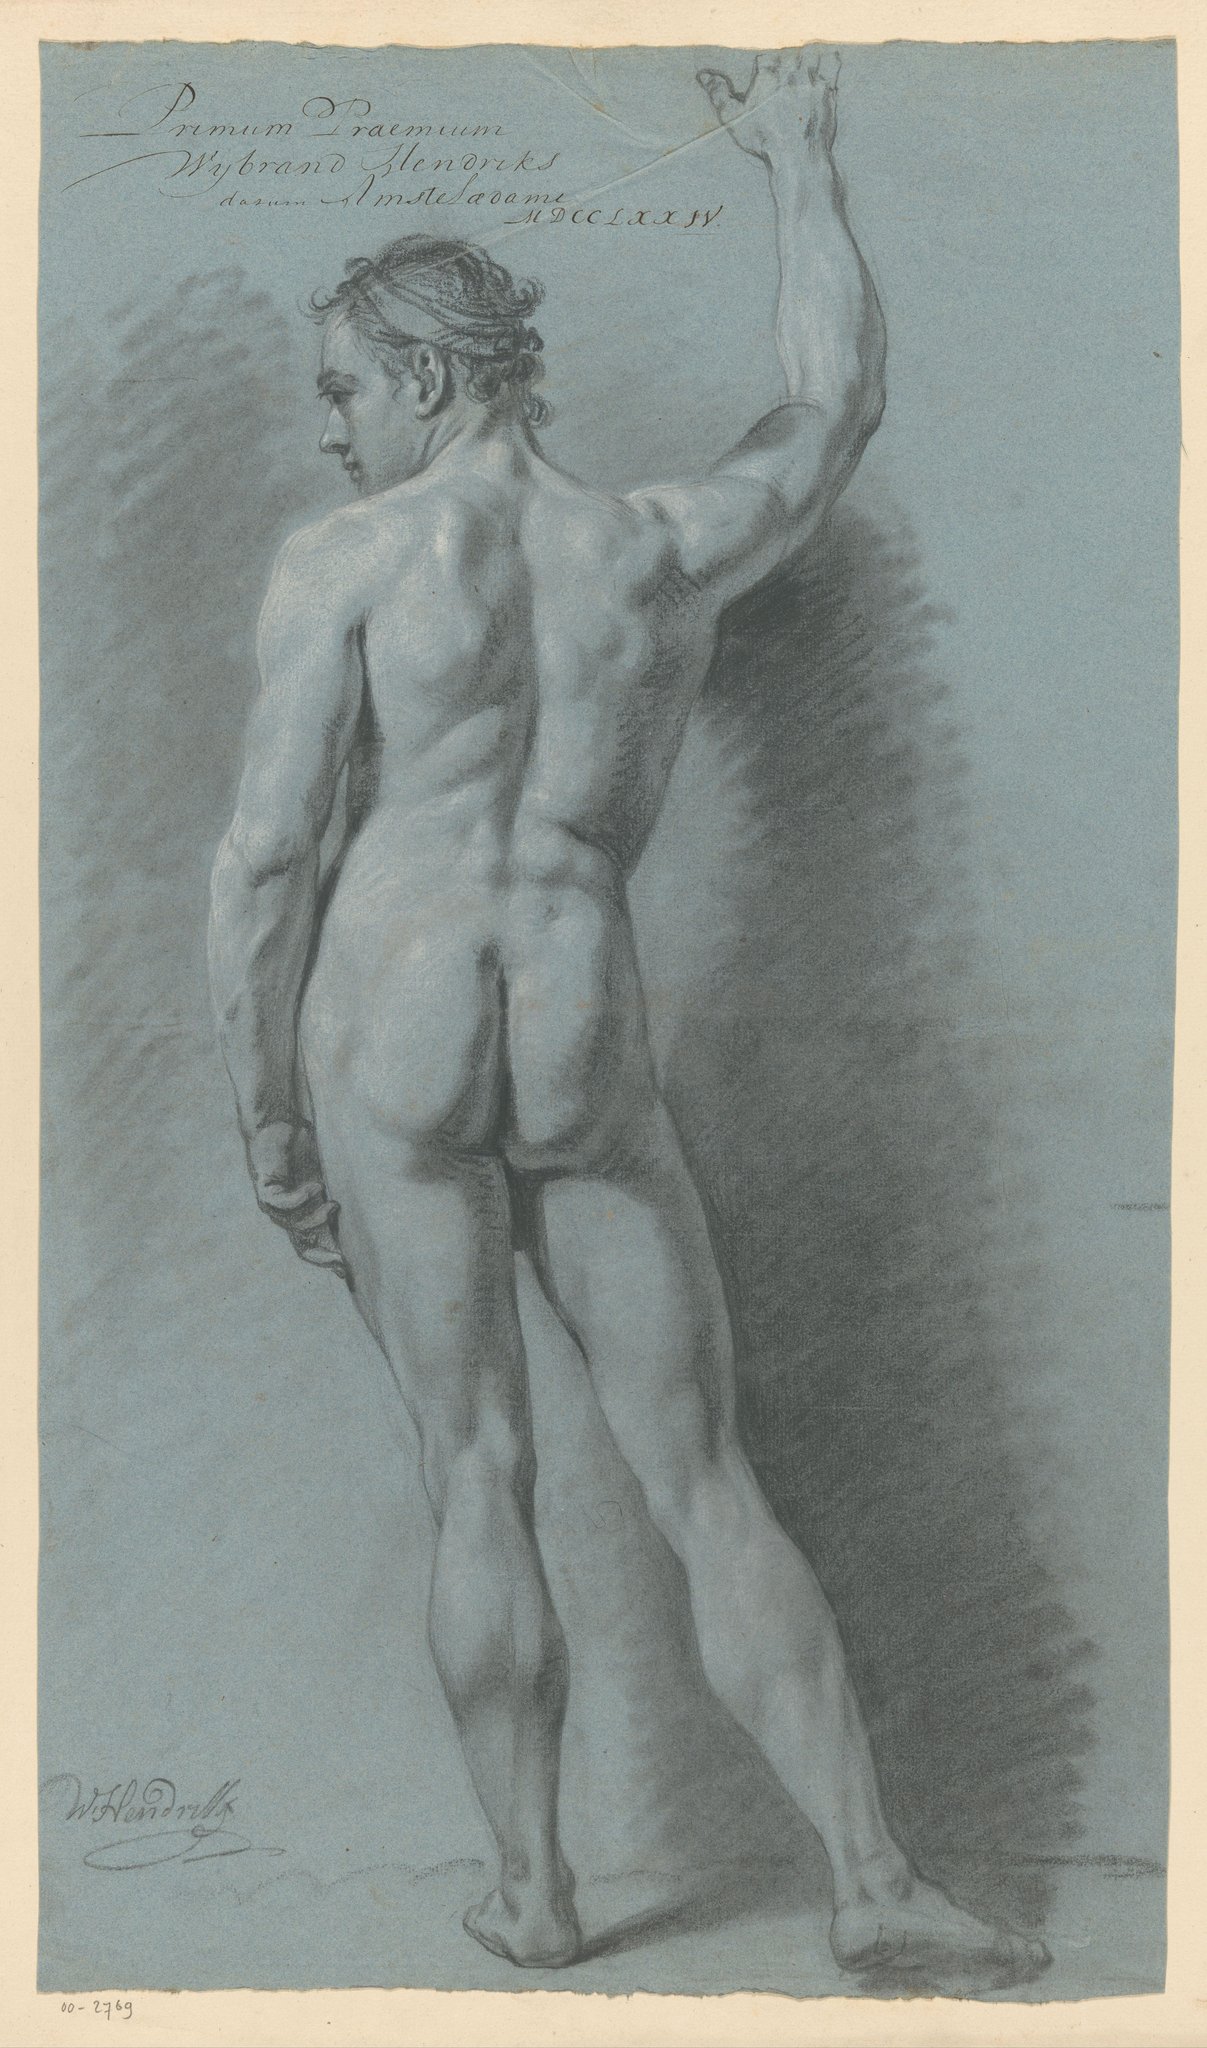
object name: drawing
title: Staand mannelijk naakt, op de rug gezien (1e prijs 1774)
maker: wybrand hendriks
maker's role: draughtsman, painter, print maker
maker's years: 1744-1831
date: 1774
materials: chalk, paper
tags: standing figure (+ nude human being)